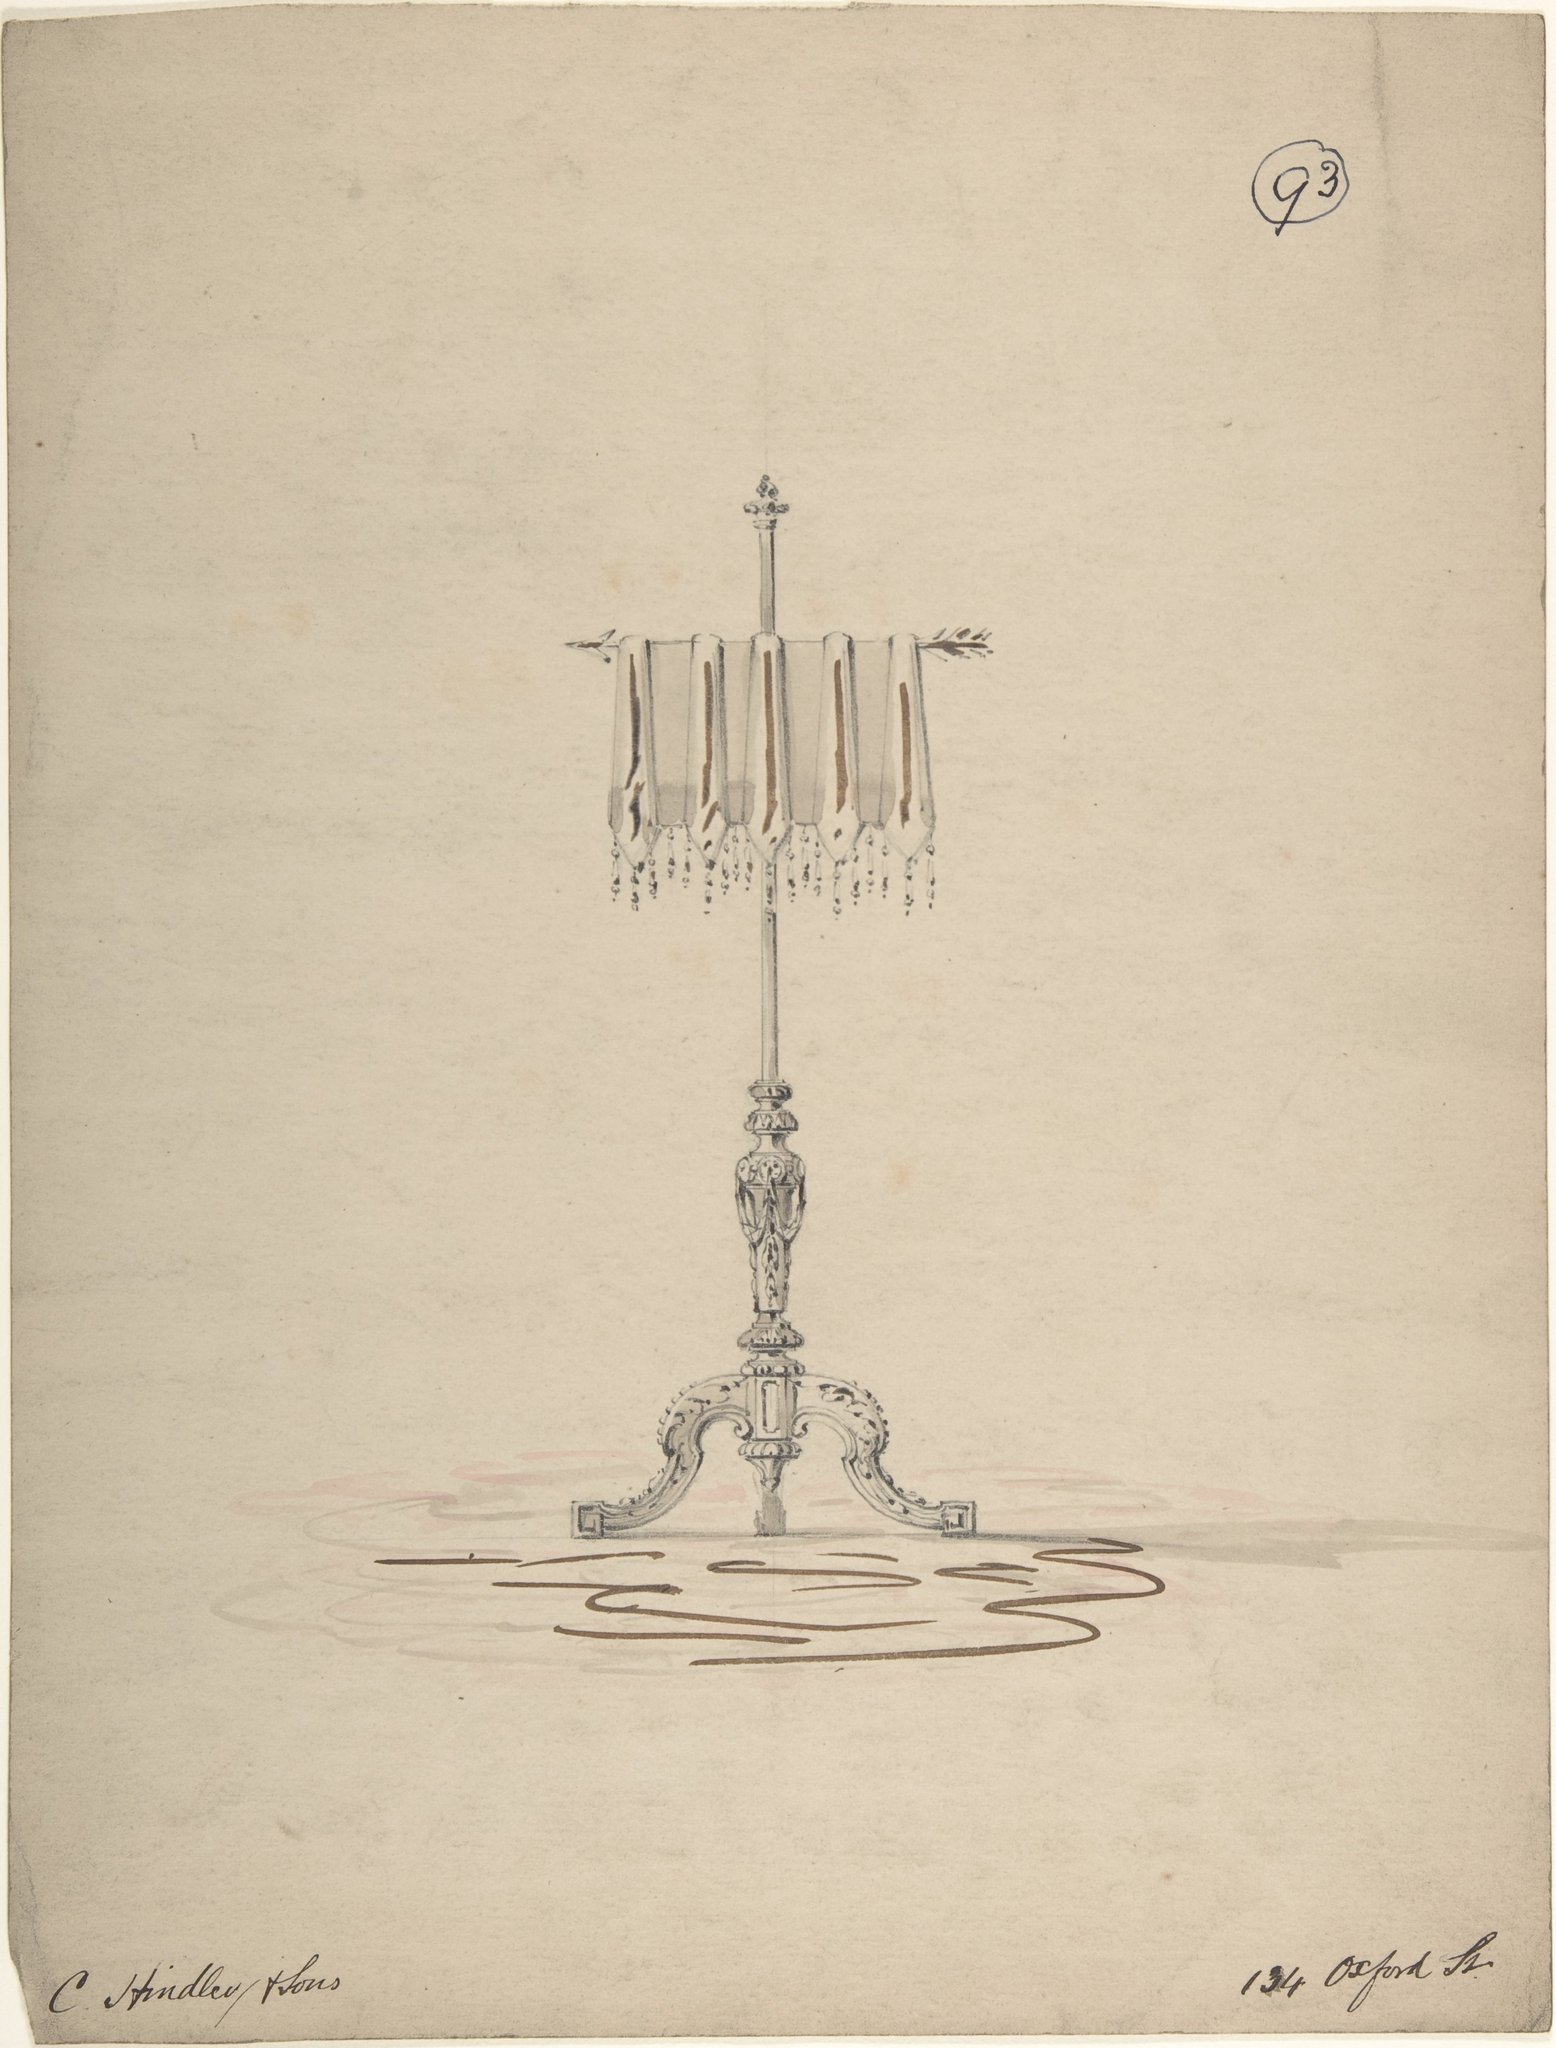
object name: drawing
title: Design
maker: charles hindley and sons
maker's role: artist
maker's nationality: british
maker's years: 1841-1917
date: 1841-1884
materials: graphite, watercolor